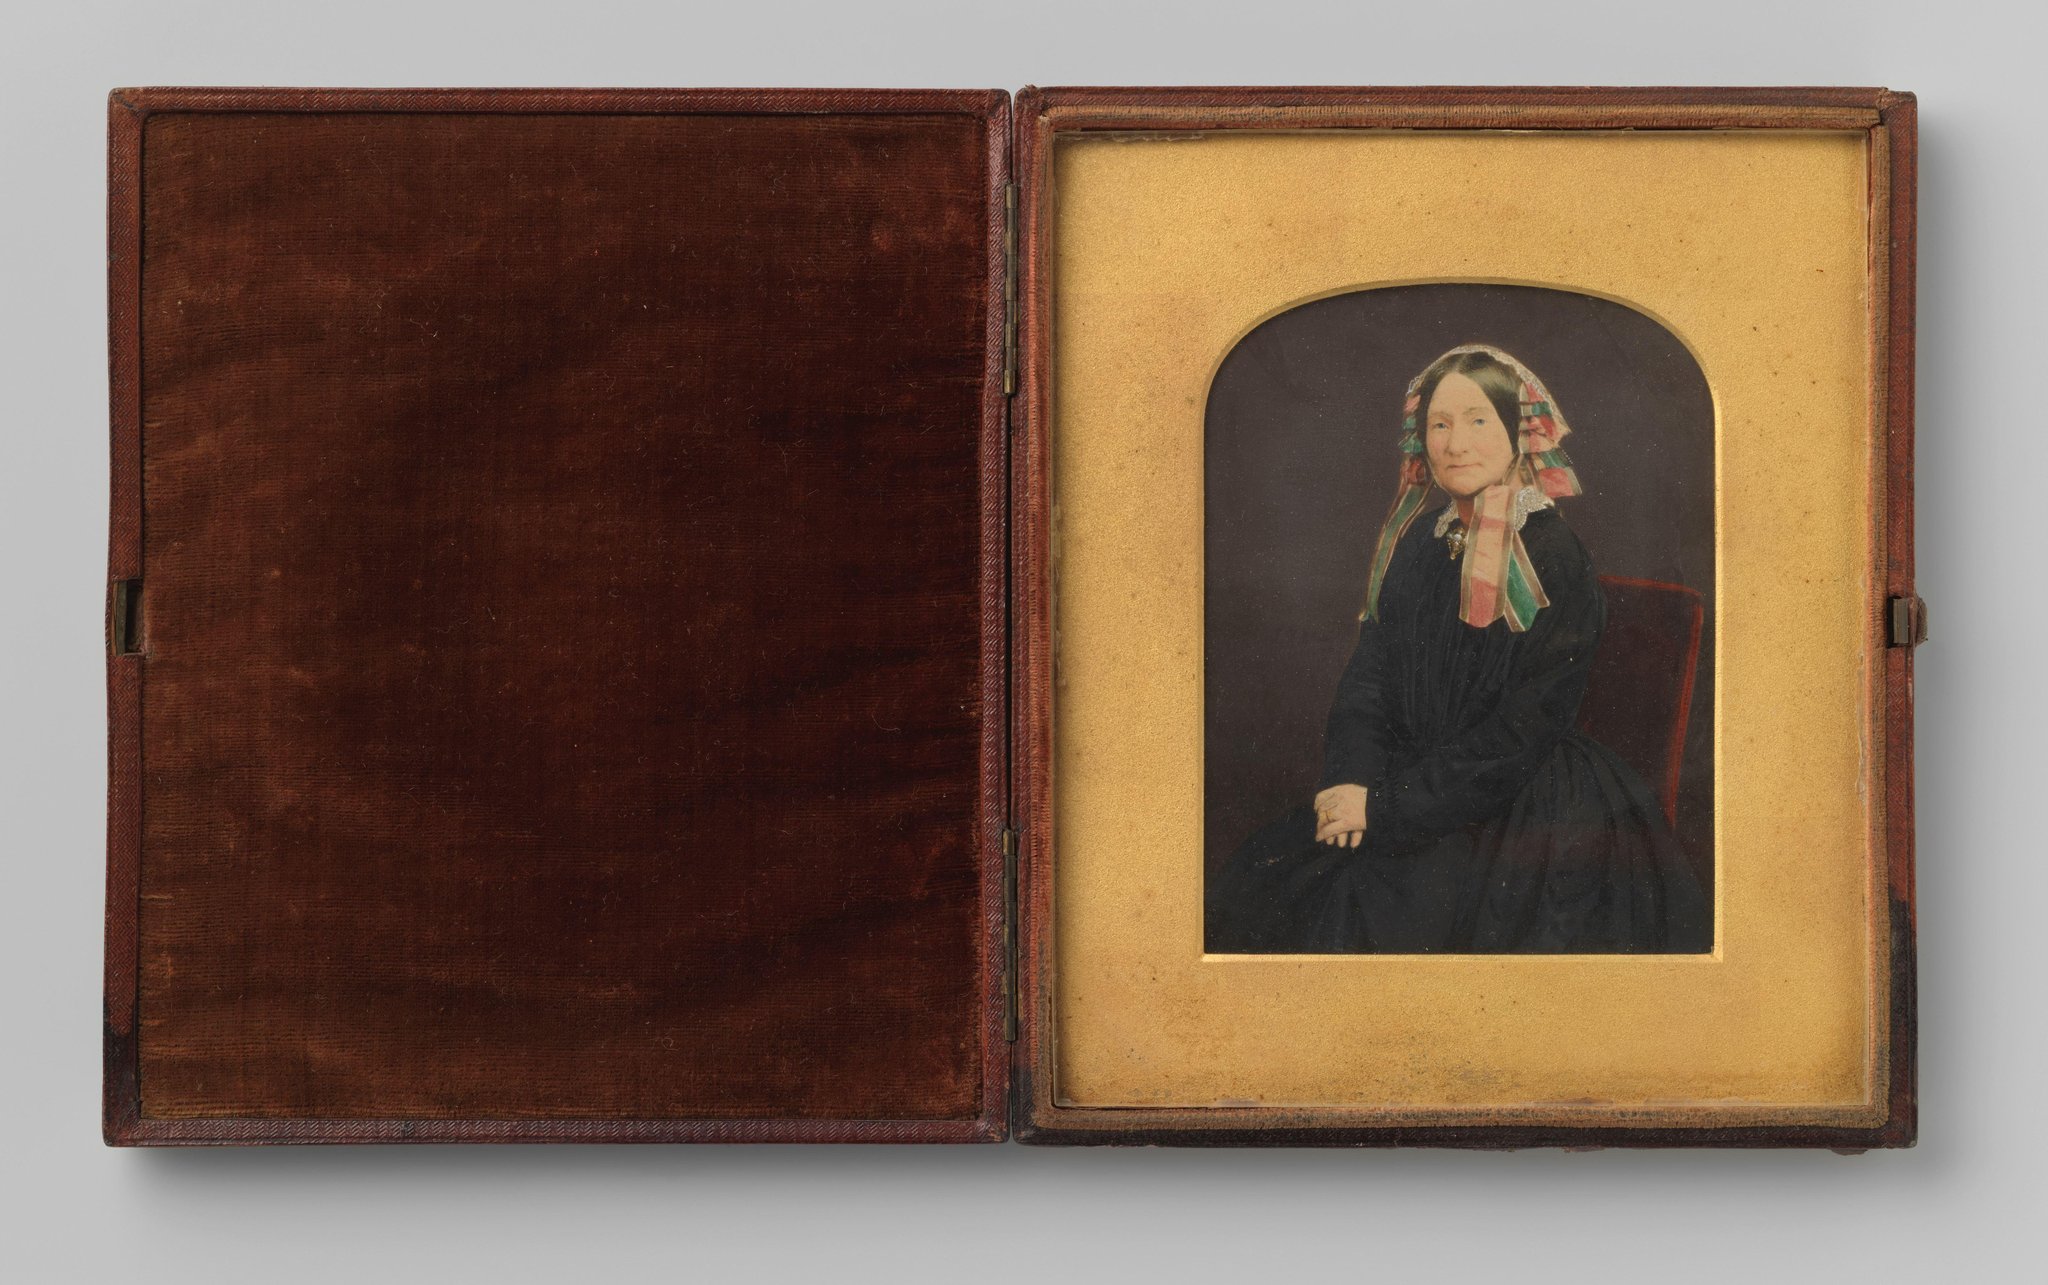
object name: photograph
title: Portret van een onbekende zittende vrouw met muts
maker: lock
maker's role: fotograaf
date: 1870-1890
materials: leather, metal, paper, textile, wood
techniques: photographie peinte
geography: london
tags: head-gear: cap, anonymous historical person portrayed - bb - woman